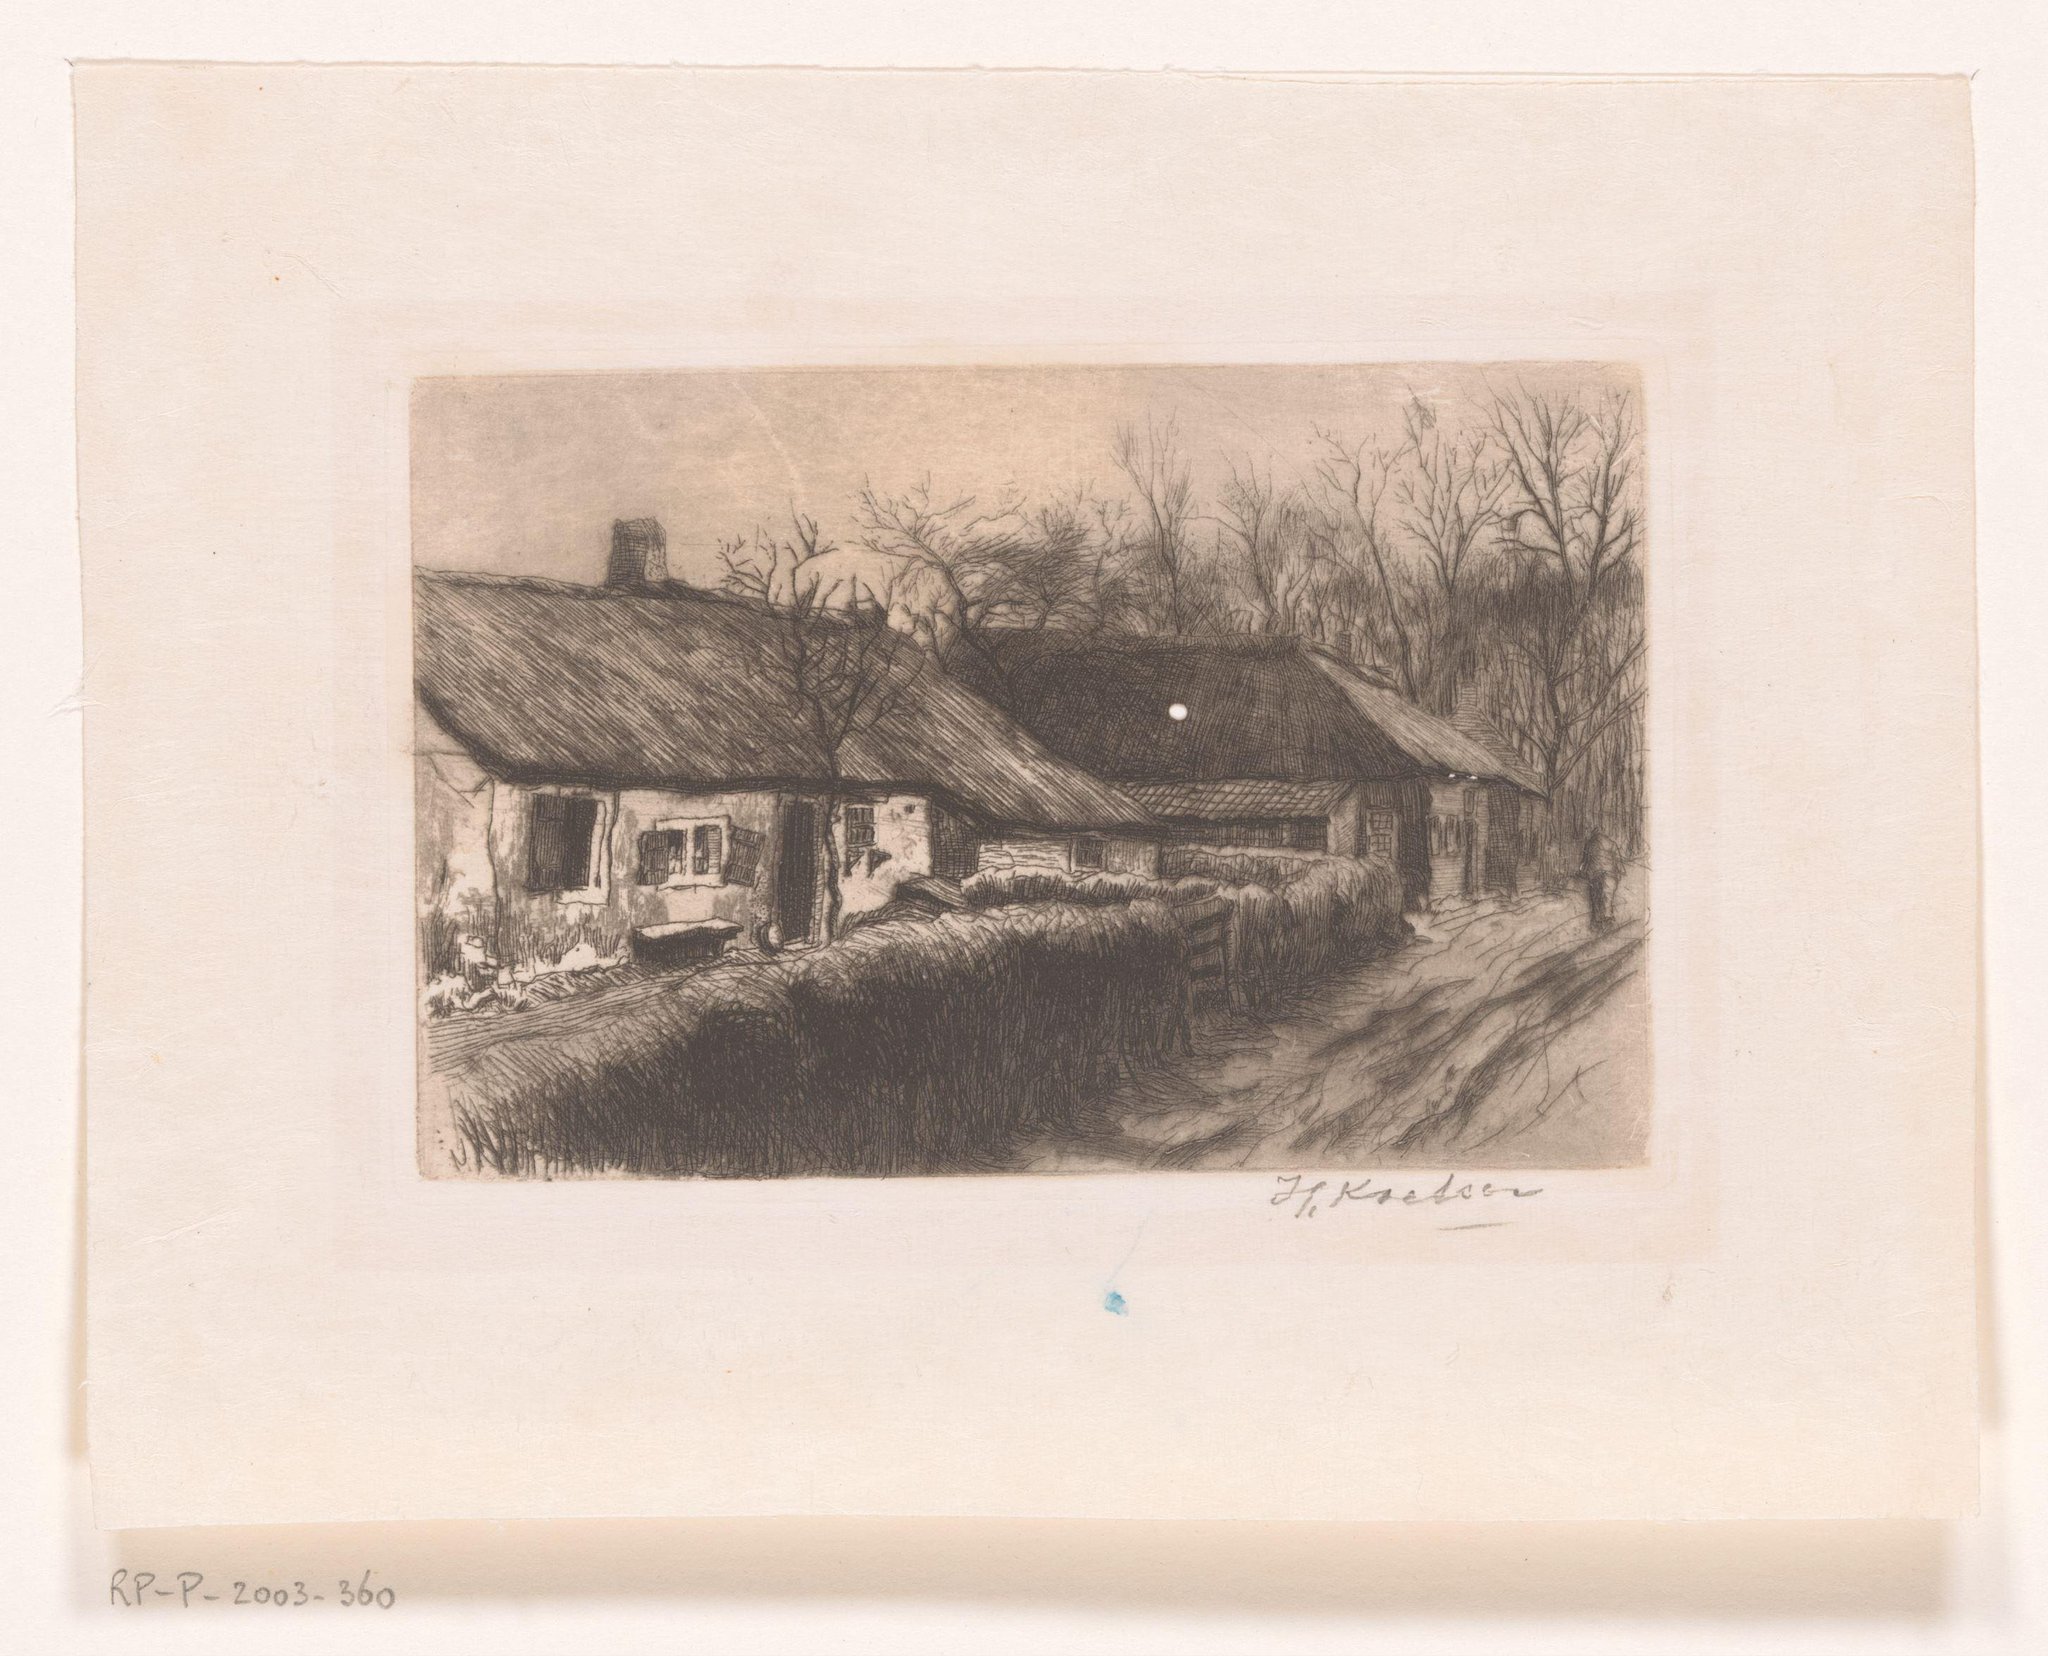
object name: print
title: Boerderijen aan een pad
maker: henri koetser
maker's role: print maker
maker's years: 1878-1952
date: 1888-1952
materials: paper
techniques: etching, intaglio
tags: farm (building)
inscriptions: collector's mark: Lugt 2228